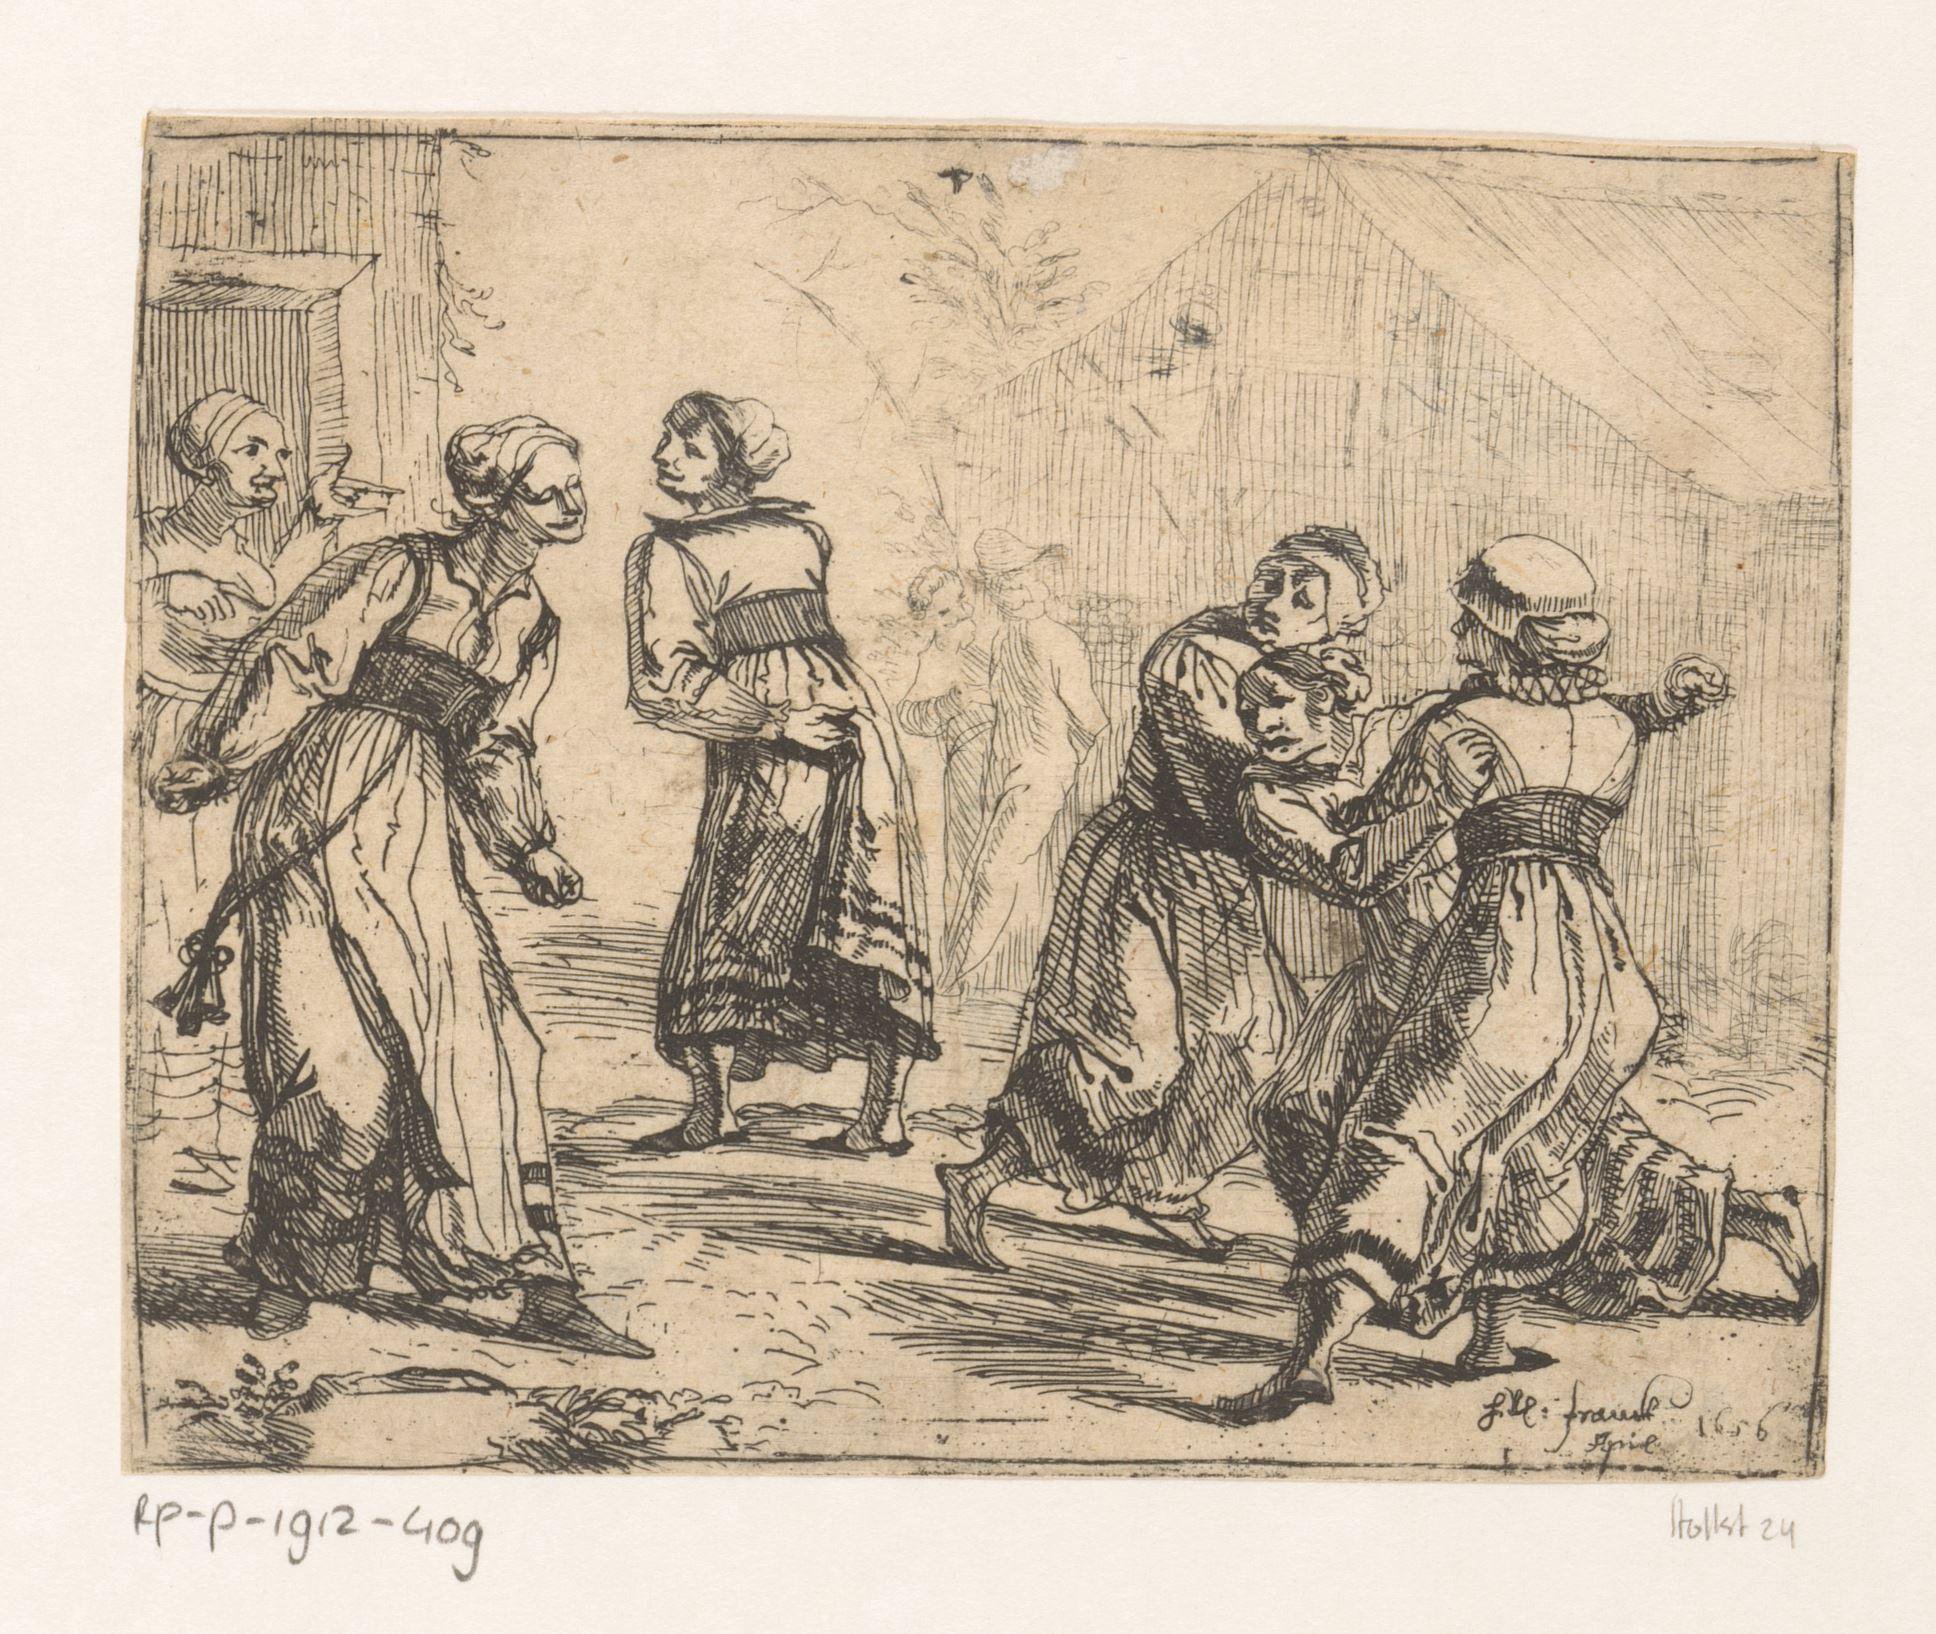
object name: print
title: Ruziënde vrouwen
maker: hans ulrich franck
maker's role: draughtsman, print maker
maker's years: 1603-1680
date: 1604-1656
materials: paper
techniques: etching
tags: adult woman, quarrel, argument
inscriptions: collector's mark: Lugt 2241, collector's mark: Lugt 2228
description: Prent uit een serie van vijfentwintig militaire voorstellingen, waarvan tien in de collectie van het RMA aanwezig zijn.